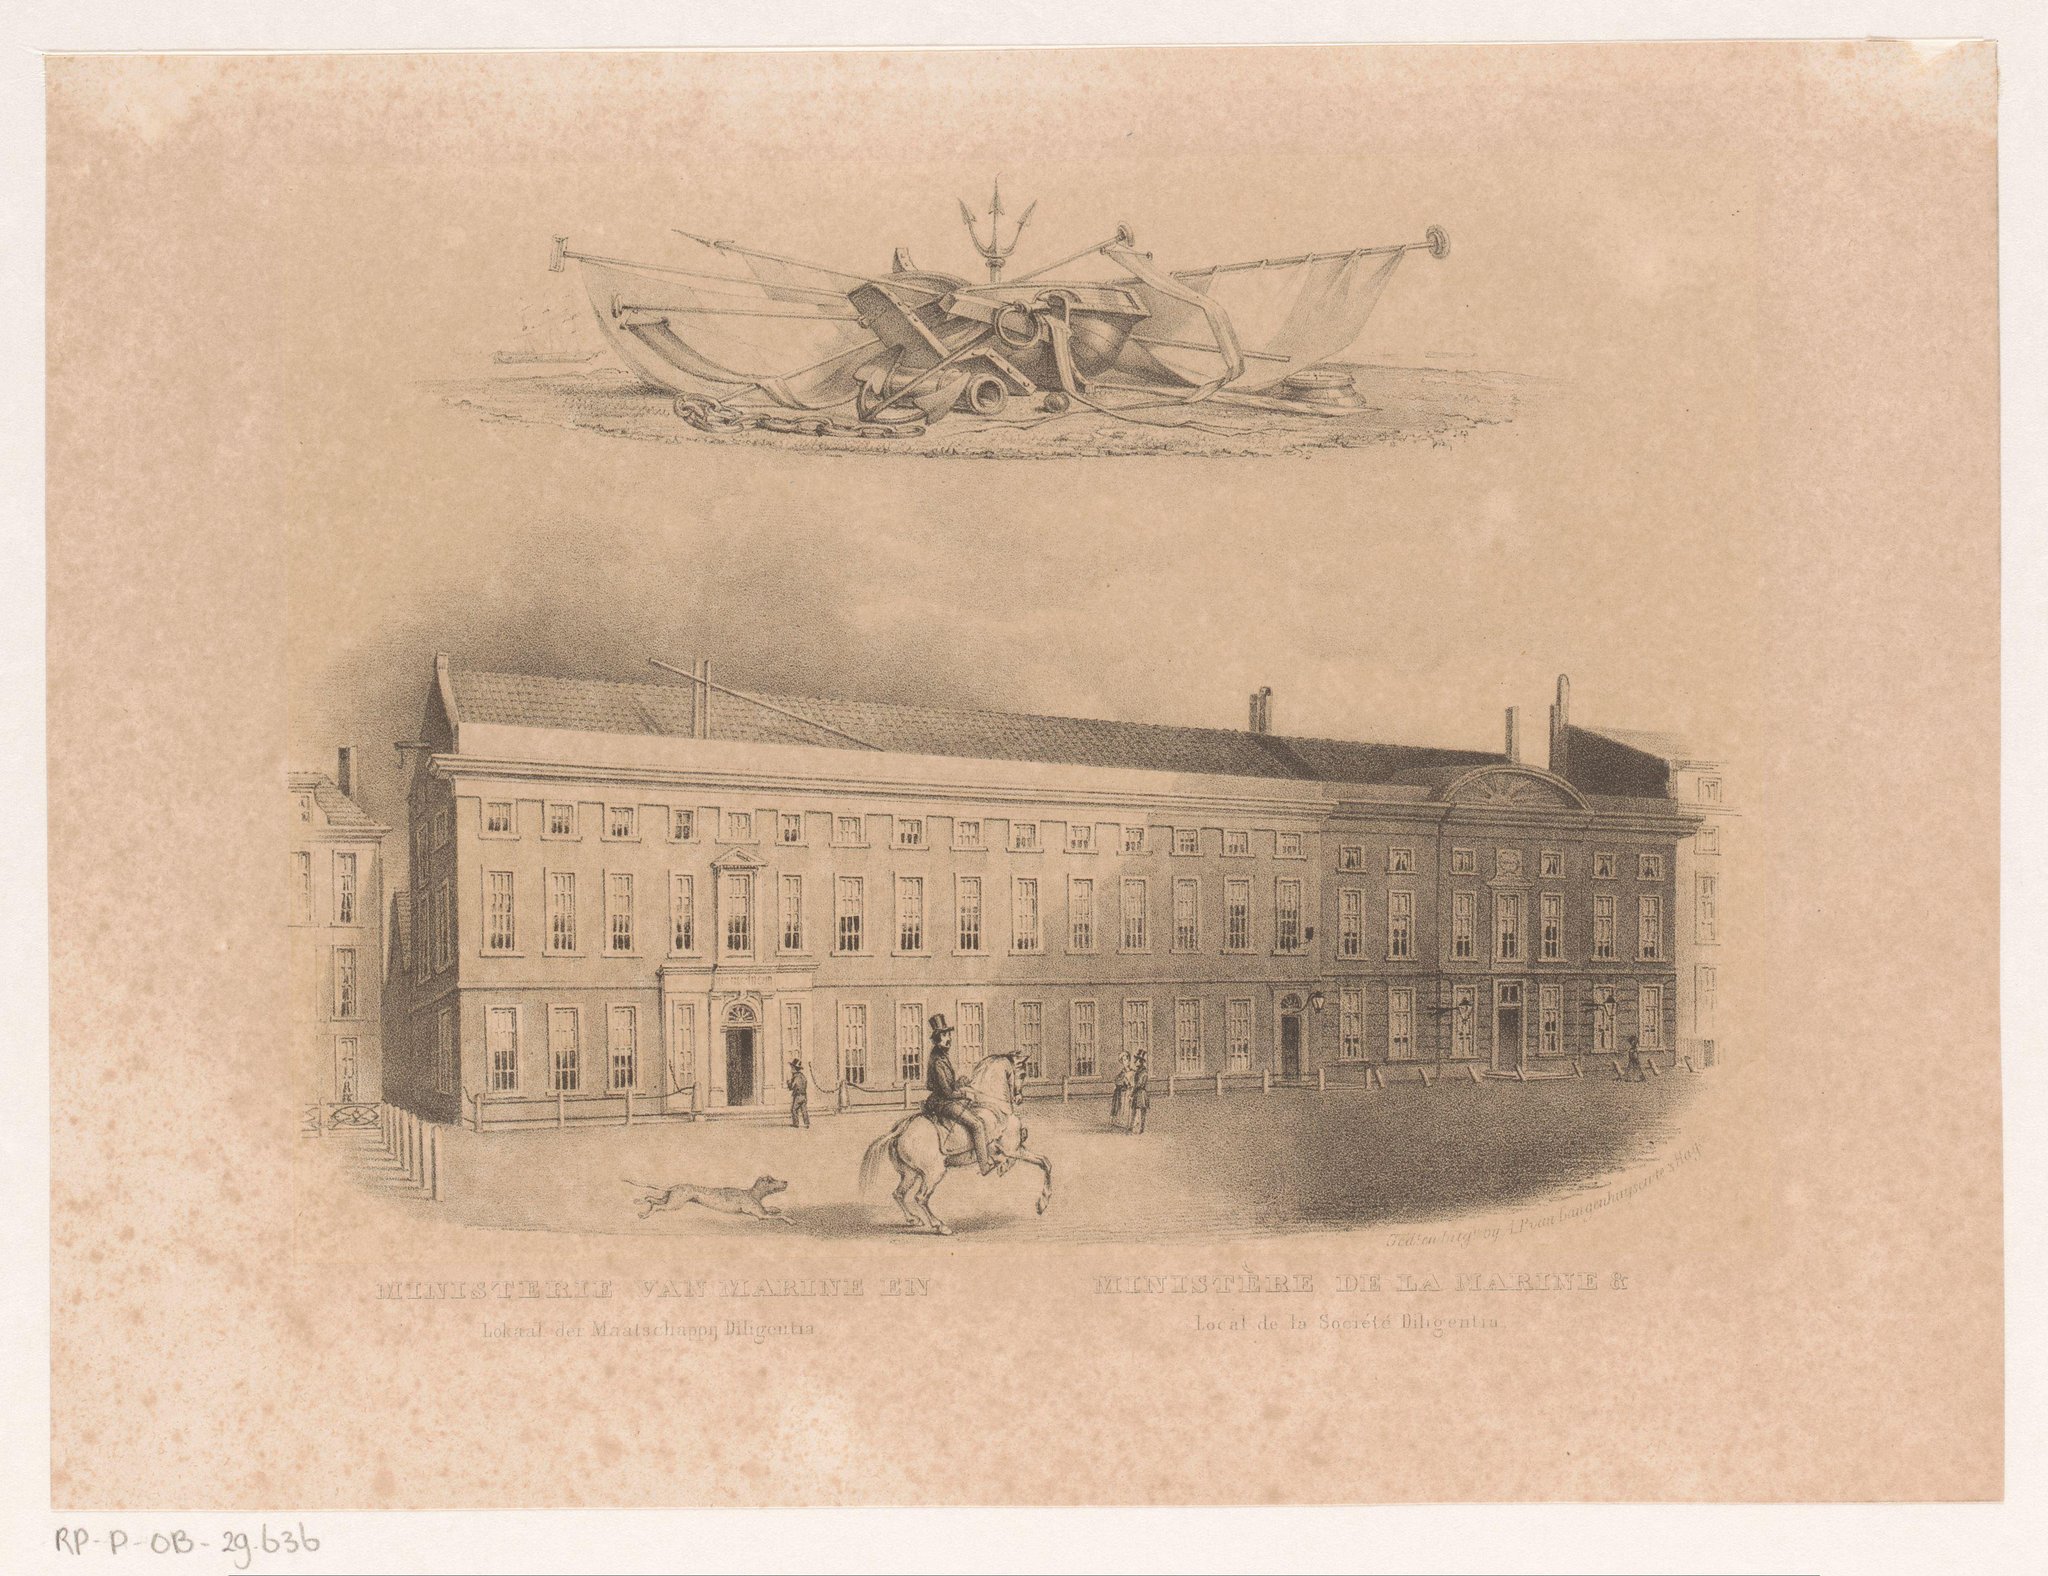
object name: print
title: Ministerie van Marine en Lokaal der Maatschappij Diligentia / Ministère de la Marine & Local de la Société Diligentia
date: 1830-1846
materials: paper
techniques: tone lithography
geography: the hague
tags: façade (of house or building), the hague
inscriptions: collector's mark: Lugt 2228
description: Een ruiter te paard met hond op het plein voor het Ministerie van Marine aan de Lange Voorhout. Rechts het gebouw van genootschap Diligentia.